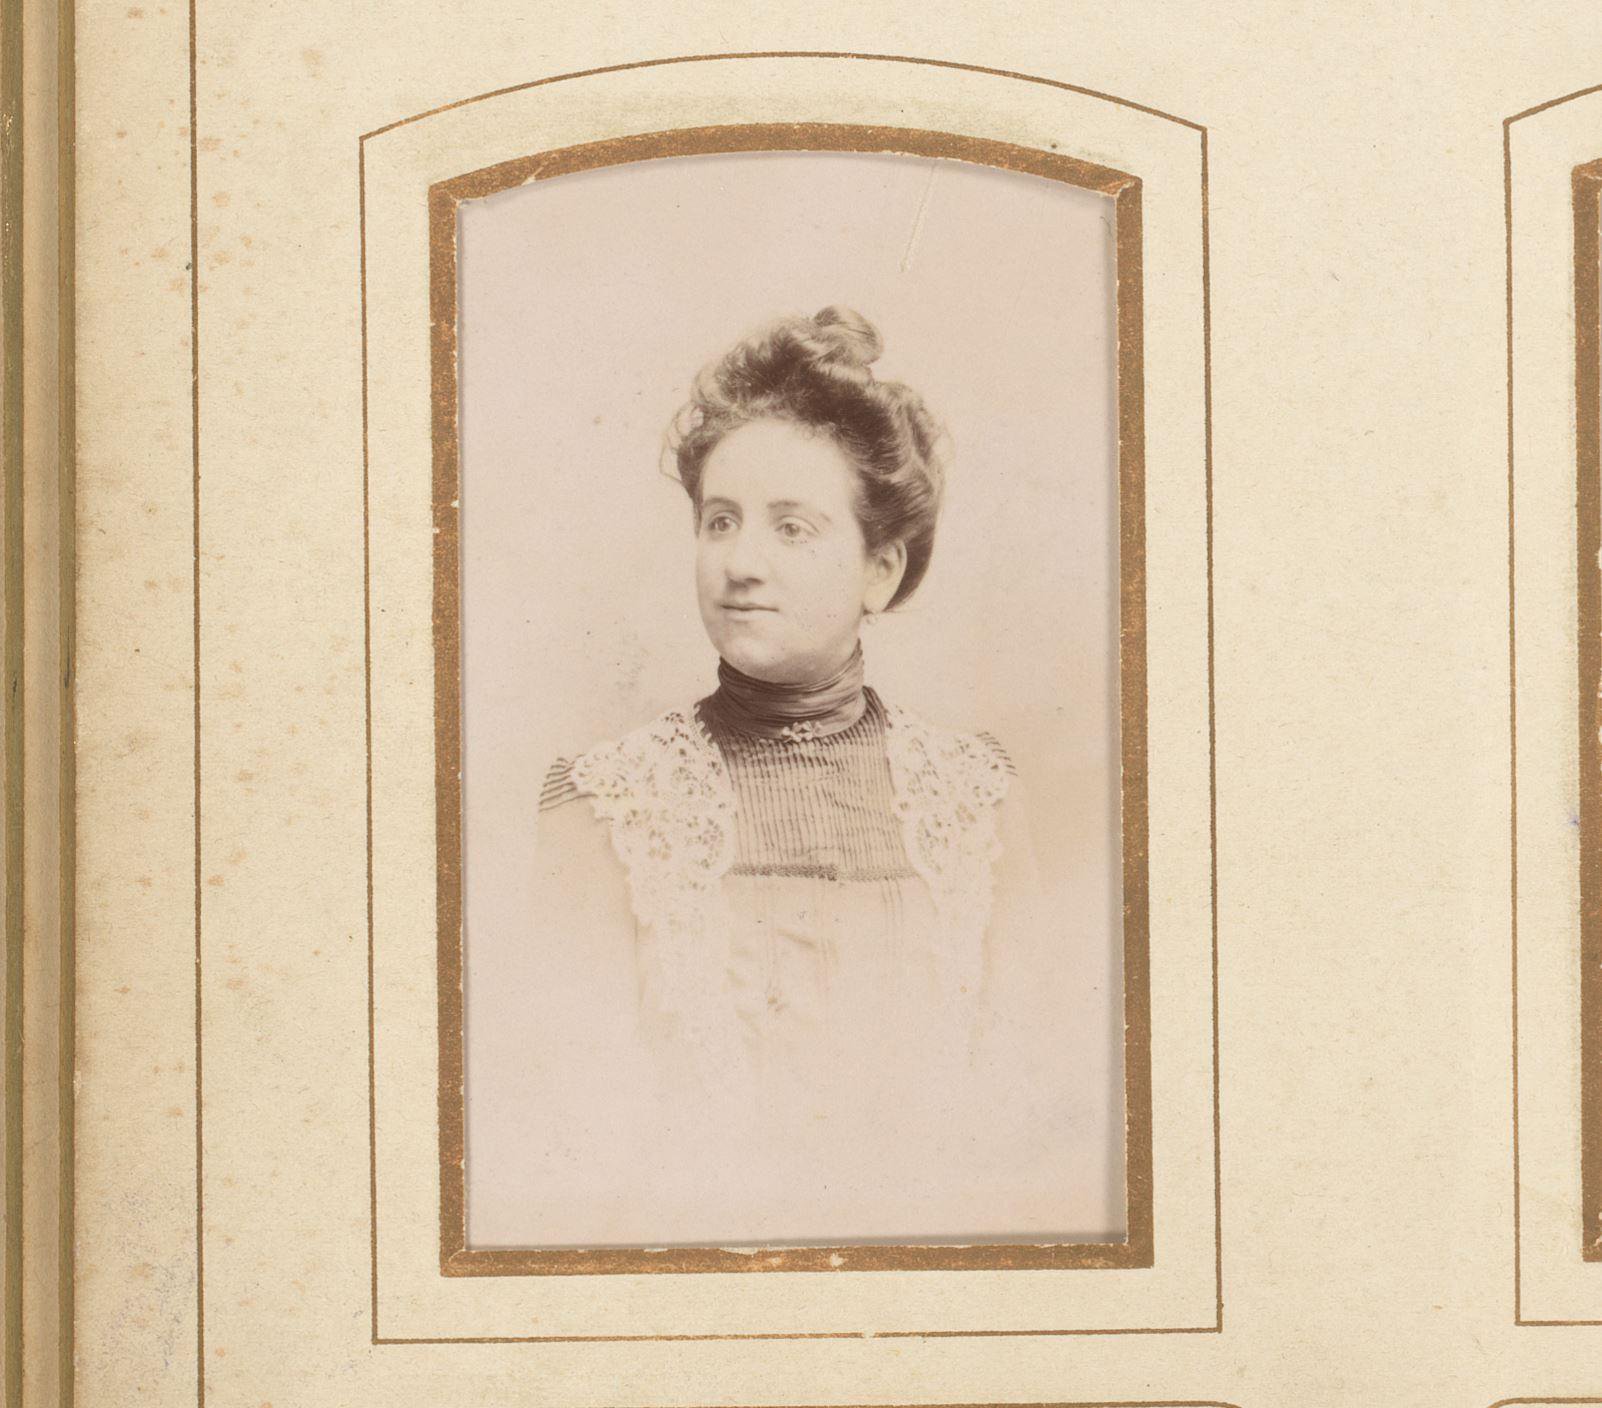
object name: photograph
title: Portret van een vrouw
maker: léon langlois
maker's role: fotograaf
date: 1860-1900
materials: cardboard, photographic support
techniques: albumen print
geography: paris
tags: historical persons - bb - woman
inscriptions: inscription: ‘L. Langlois/ 7 B.d de Strasbourg/ Paris’